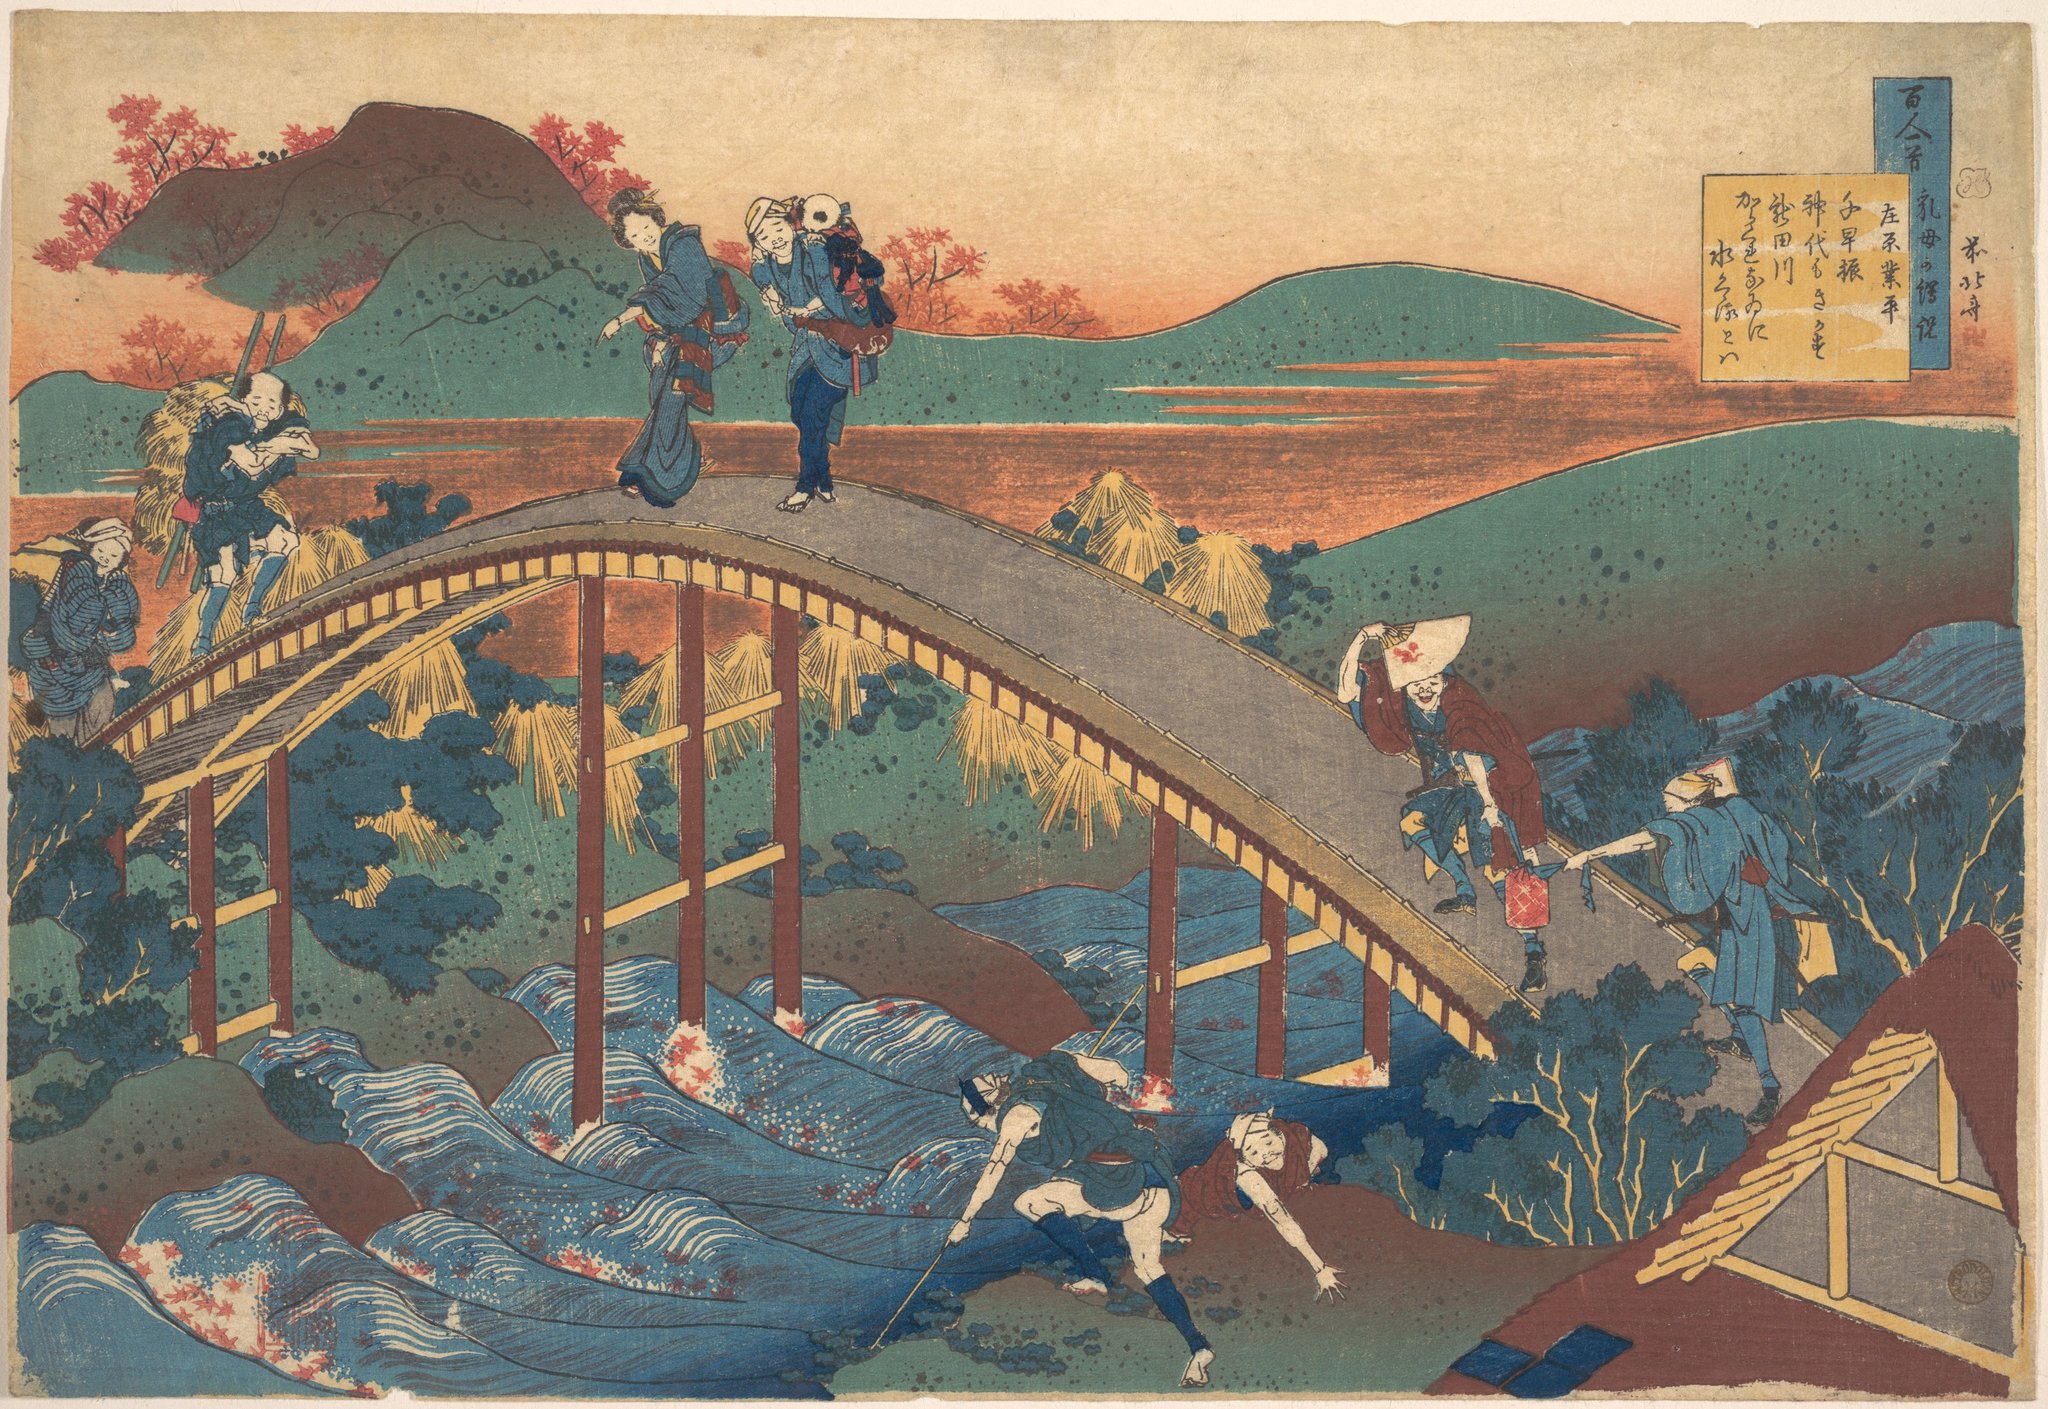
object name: woodblock print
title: Poem by Ariwara no Narihira, from the series One Hundred Poems Explained by the Nurse (Hyakunin isshu uba ga etoki)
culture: japanese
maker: katsushika hokusai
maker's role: artist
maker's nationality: japanese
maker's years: 1760-1849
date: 1839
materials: ink, paper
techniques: woodblock print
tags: bridges,men,women,rivers